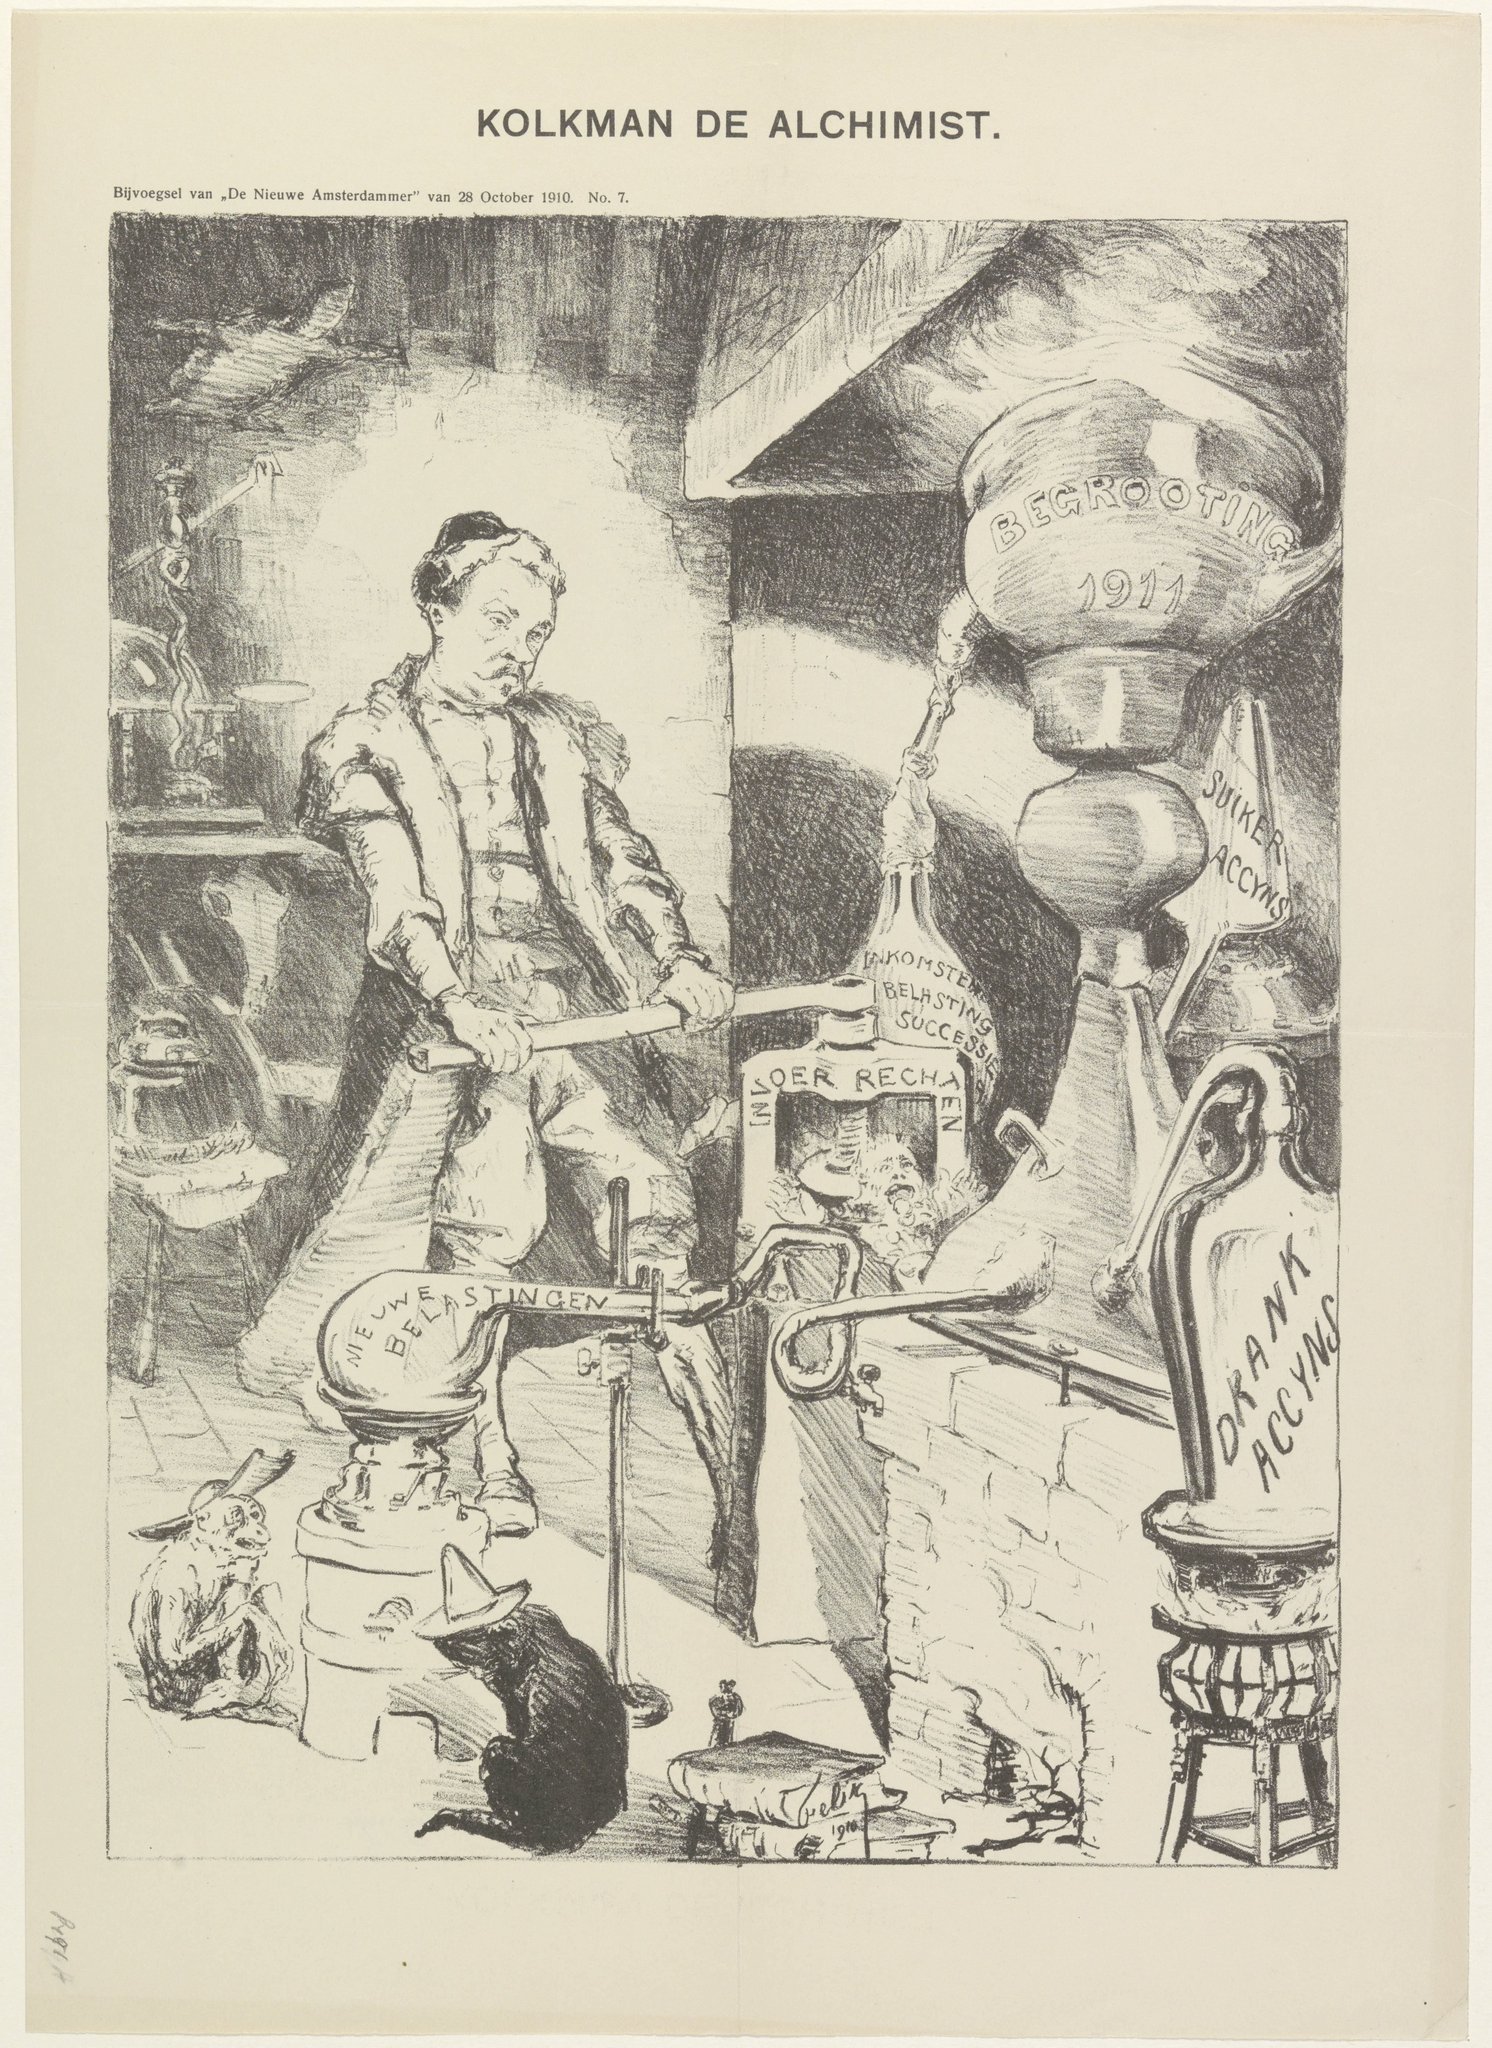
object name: cartoon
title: Kolkman de Alcimist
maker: felix hess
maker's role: draughtsman, print maker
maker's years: 1878-1943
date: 1910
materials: paper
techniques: lithograph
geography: netherlands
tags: the hague, politician, alchemist at work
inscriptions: collector's mark: Lugt 2228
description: Spotprent waarin Maximilien Kolkmannaar, minister van Financiën, voorgesteld is als een alchemist in zijn werkplaats. Verschenen als bijvoegsel van de Nieuwe Amsterdammer van 28 oktober 1910, no. 7.